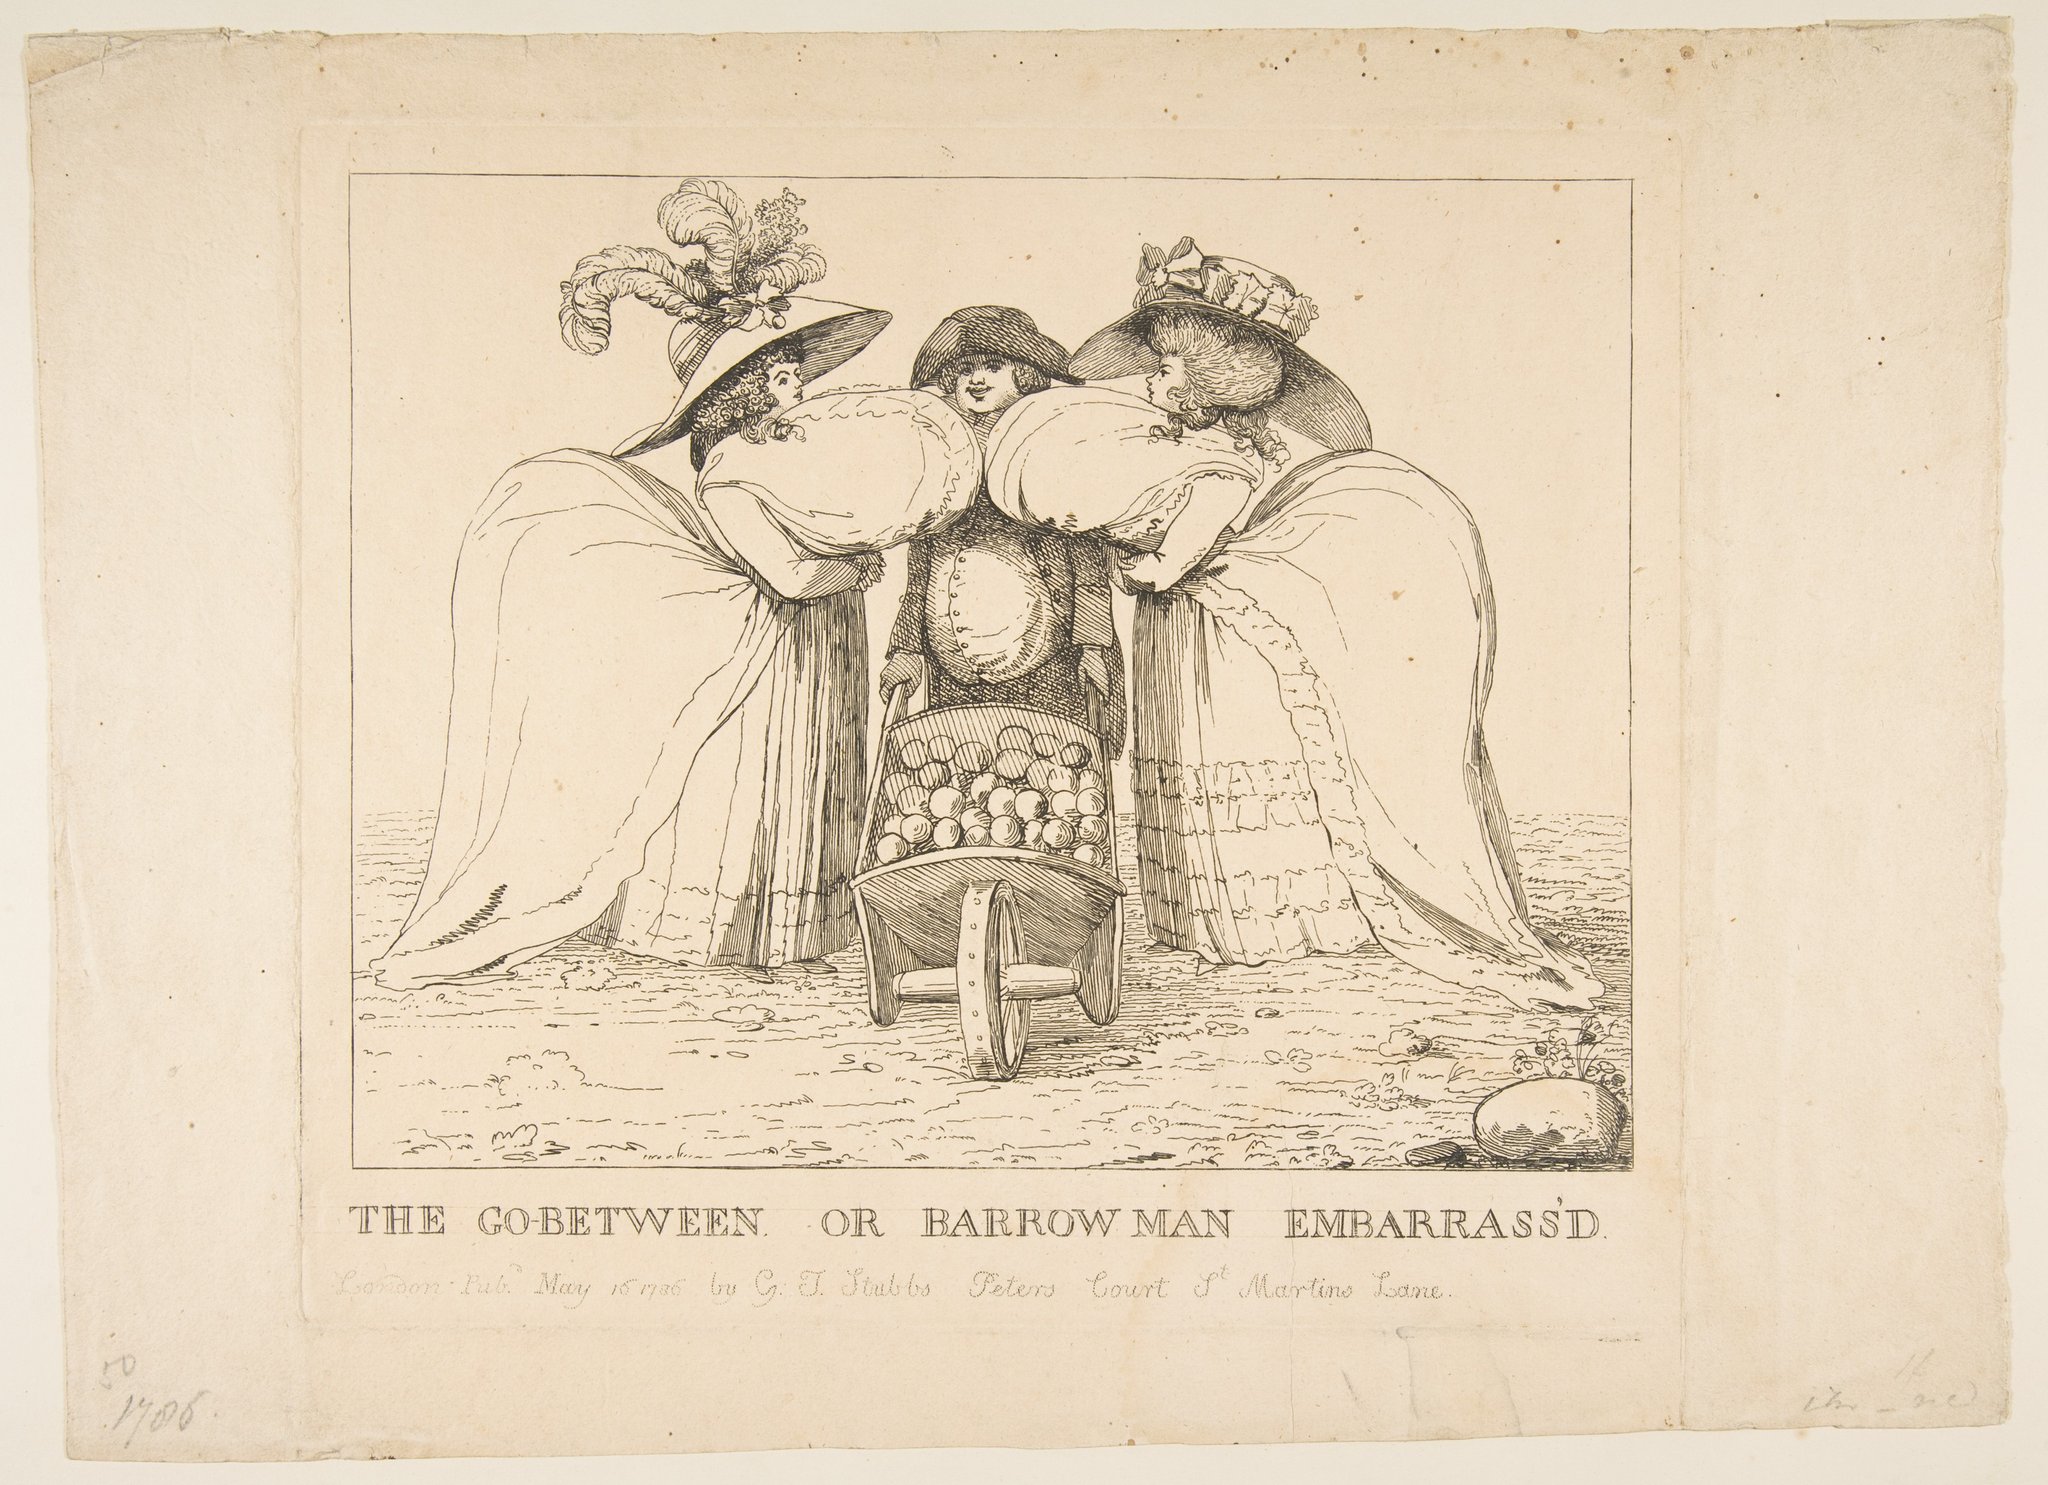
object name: print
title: The Go-Between or Barrow Man Embarrass'd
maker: george townley stubbs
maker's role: artist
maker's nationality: british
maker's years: 1756-1815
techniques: etching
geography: london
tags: satire,women